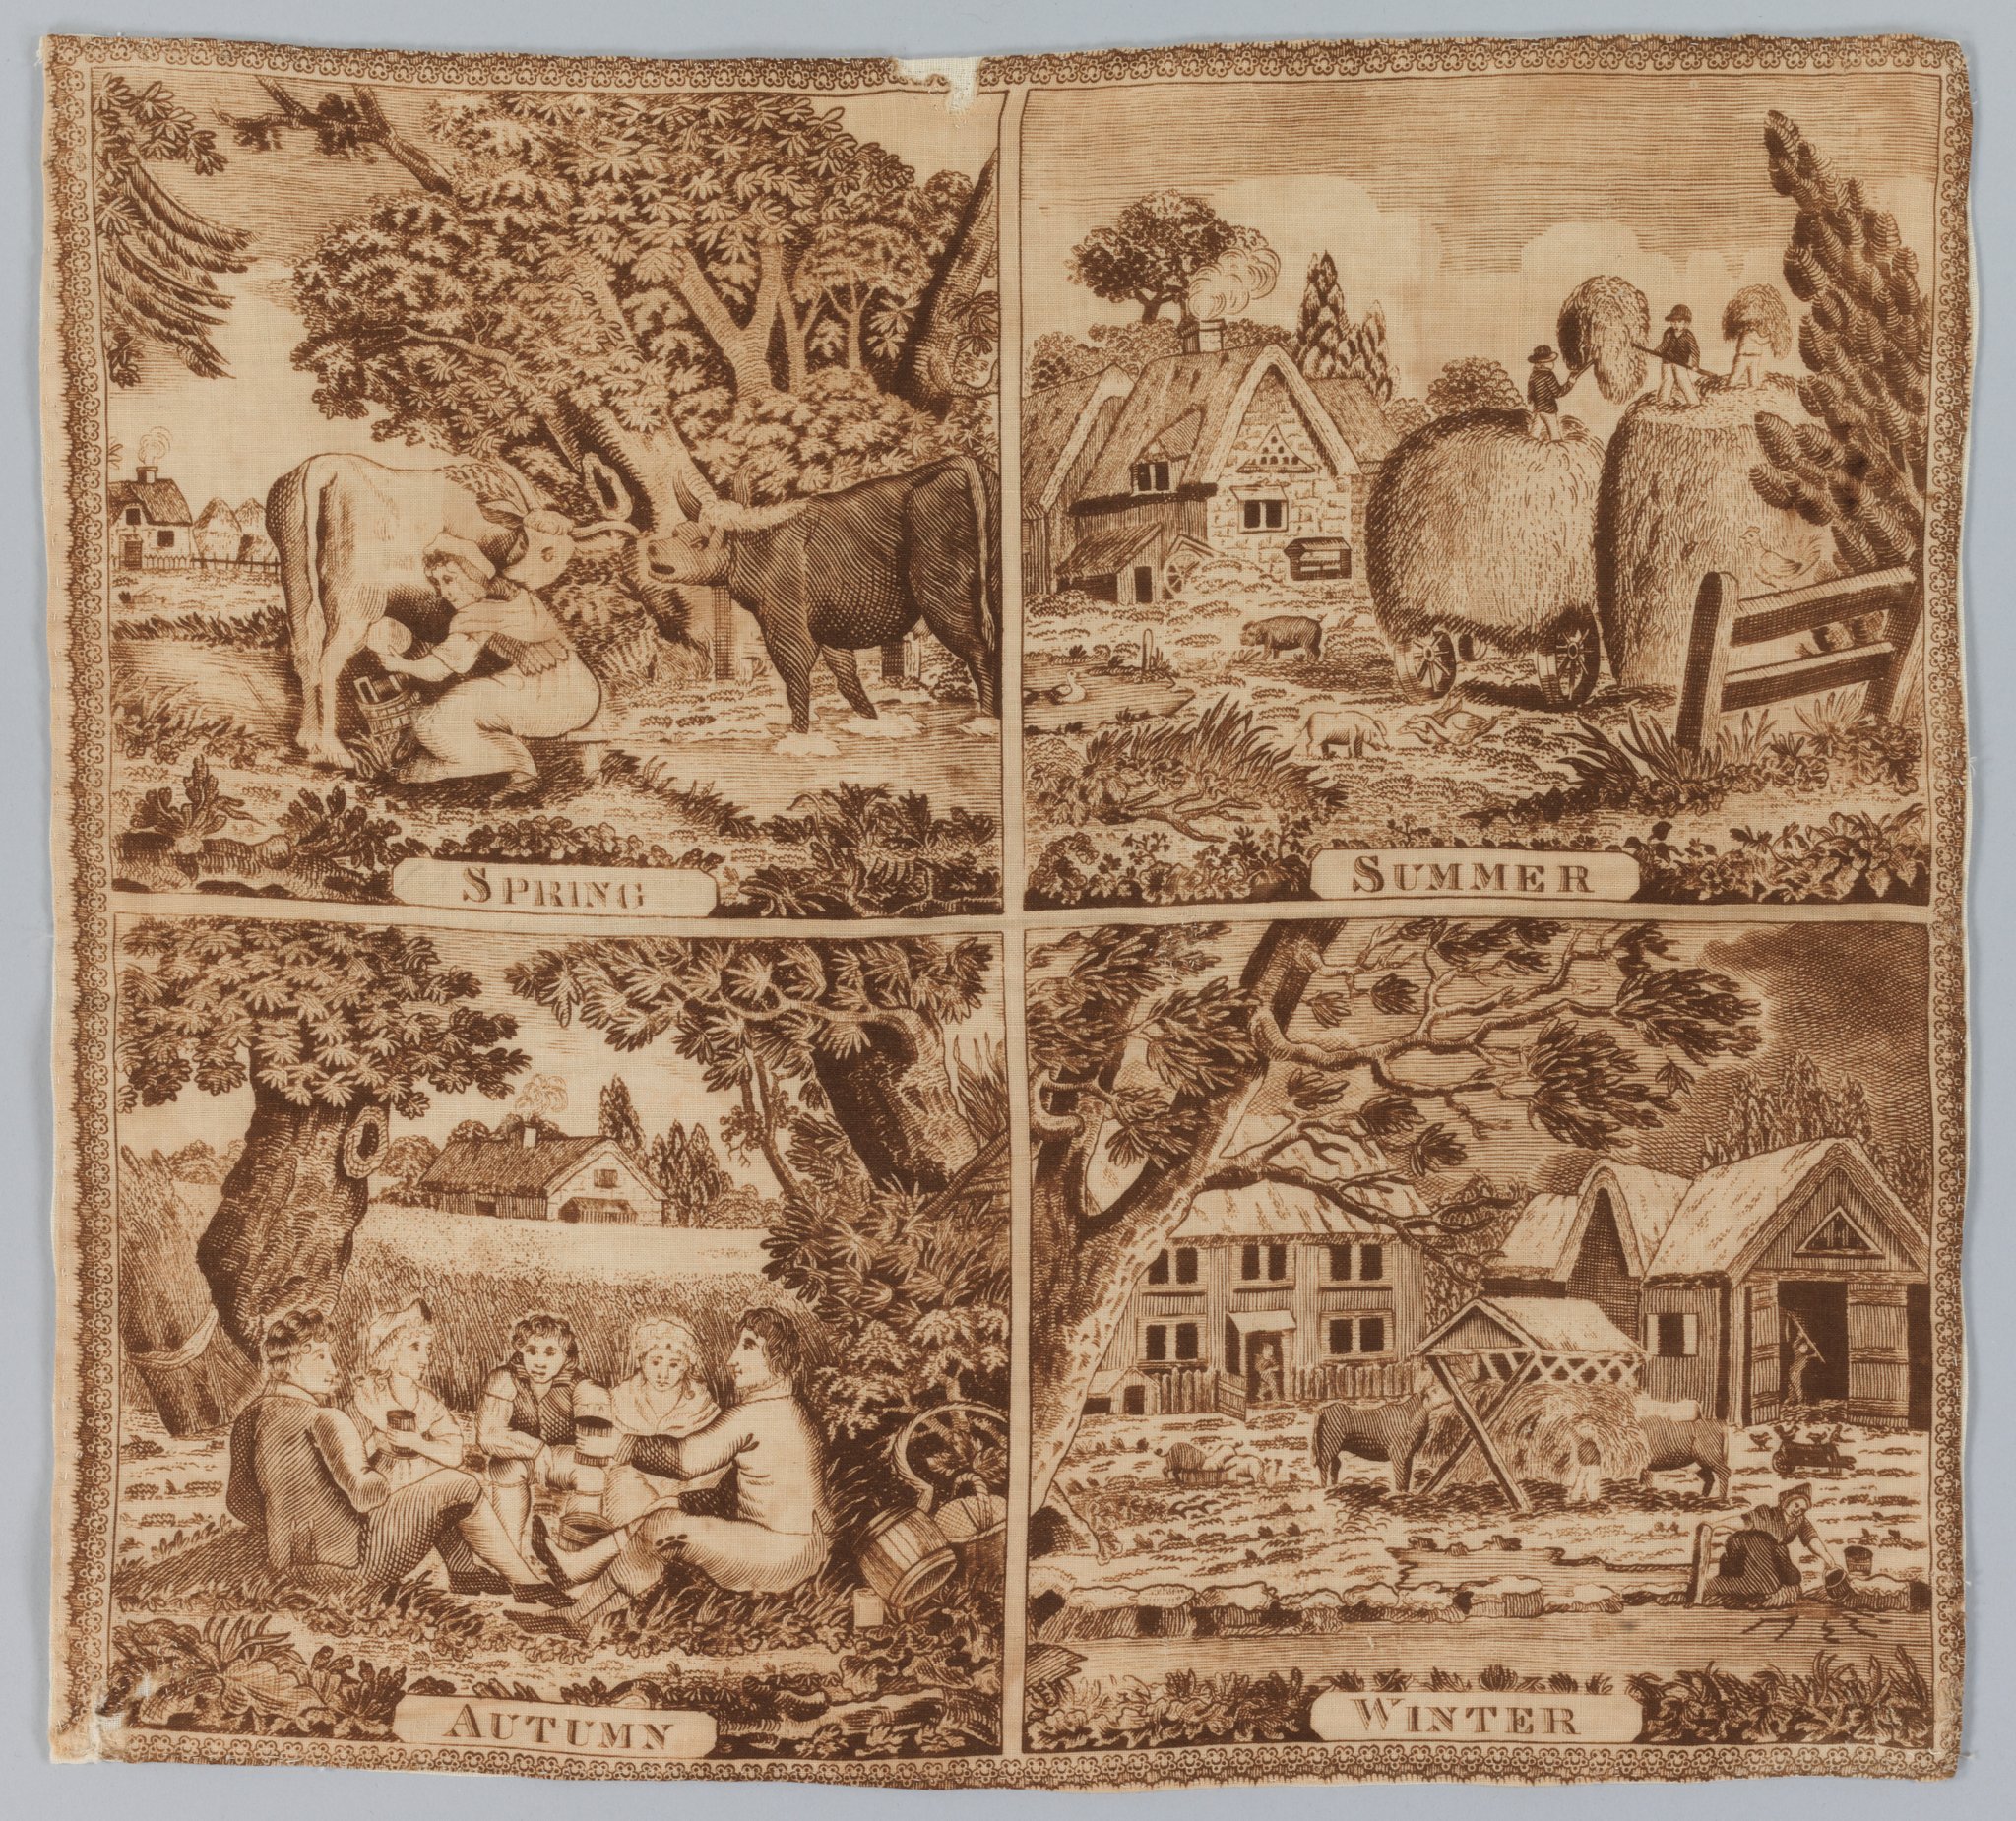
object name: handkerchief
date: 1800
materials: cotton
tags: farms,men,women,cows,drinking,working